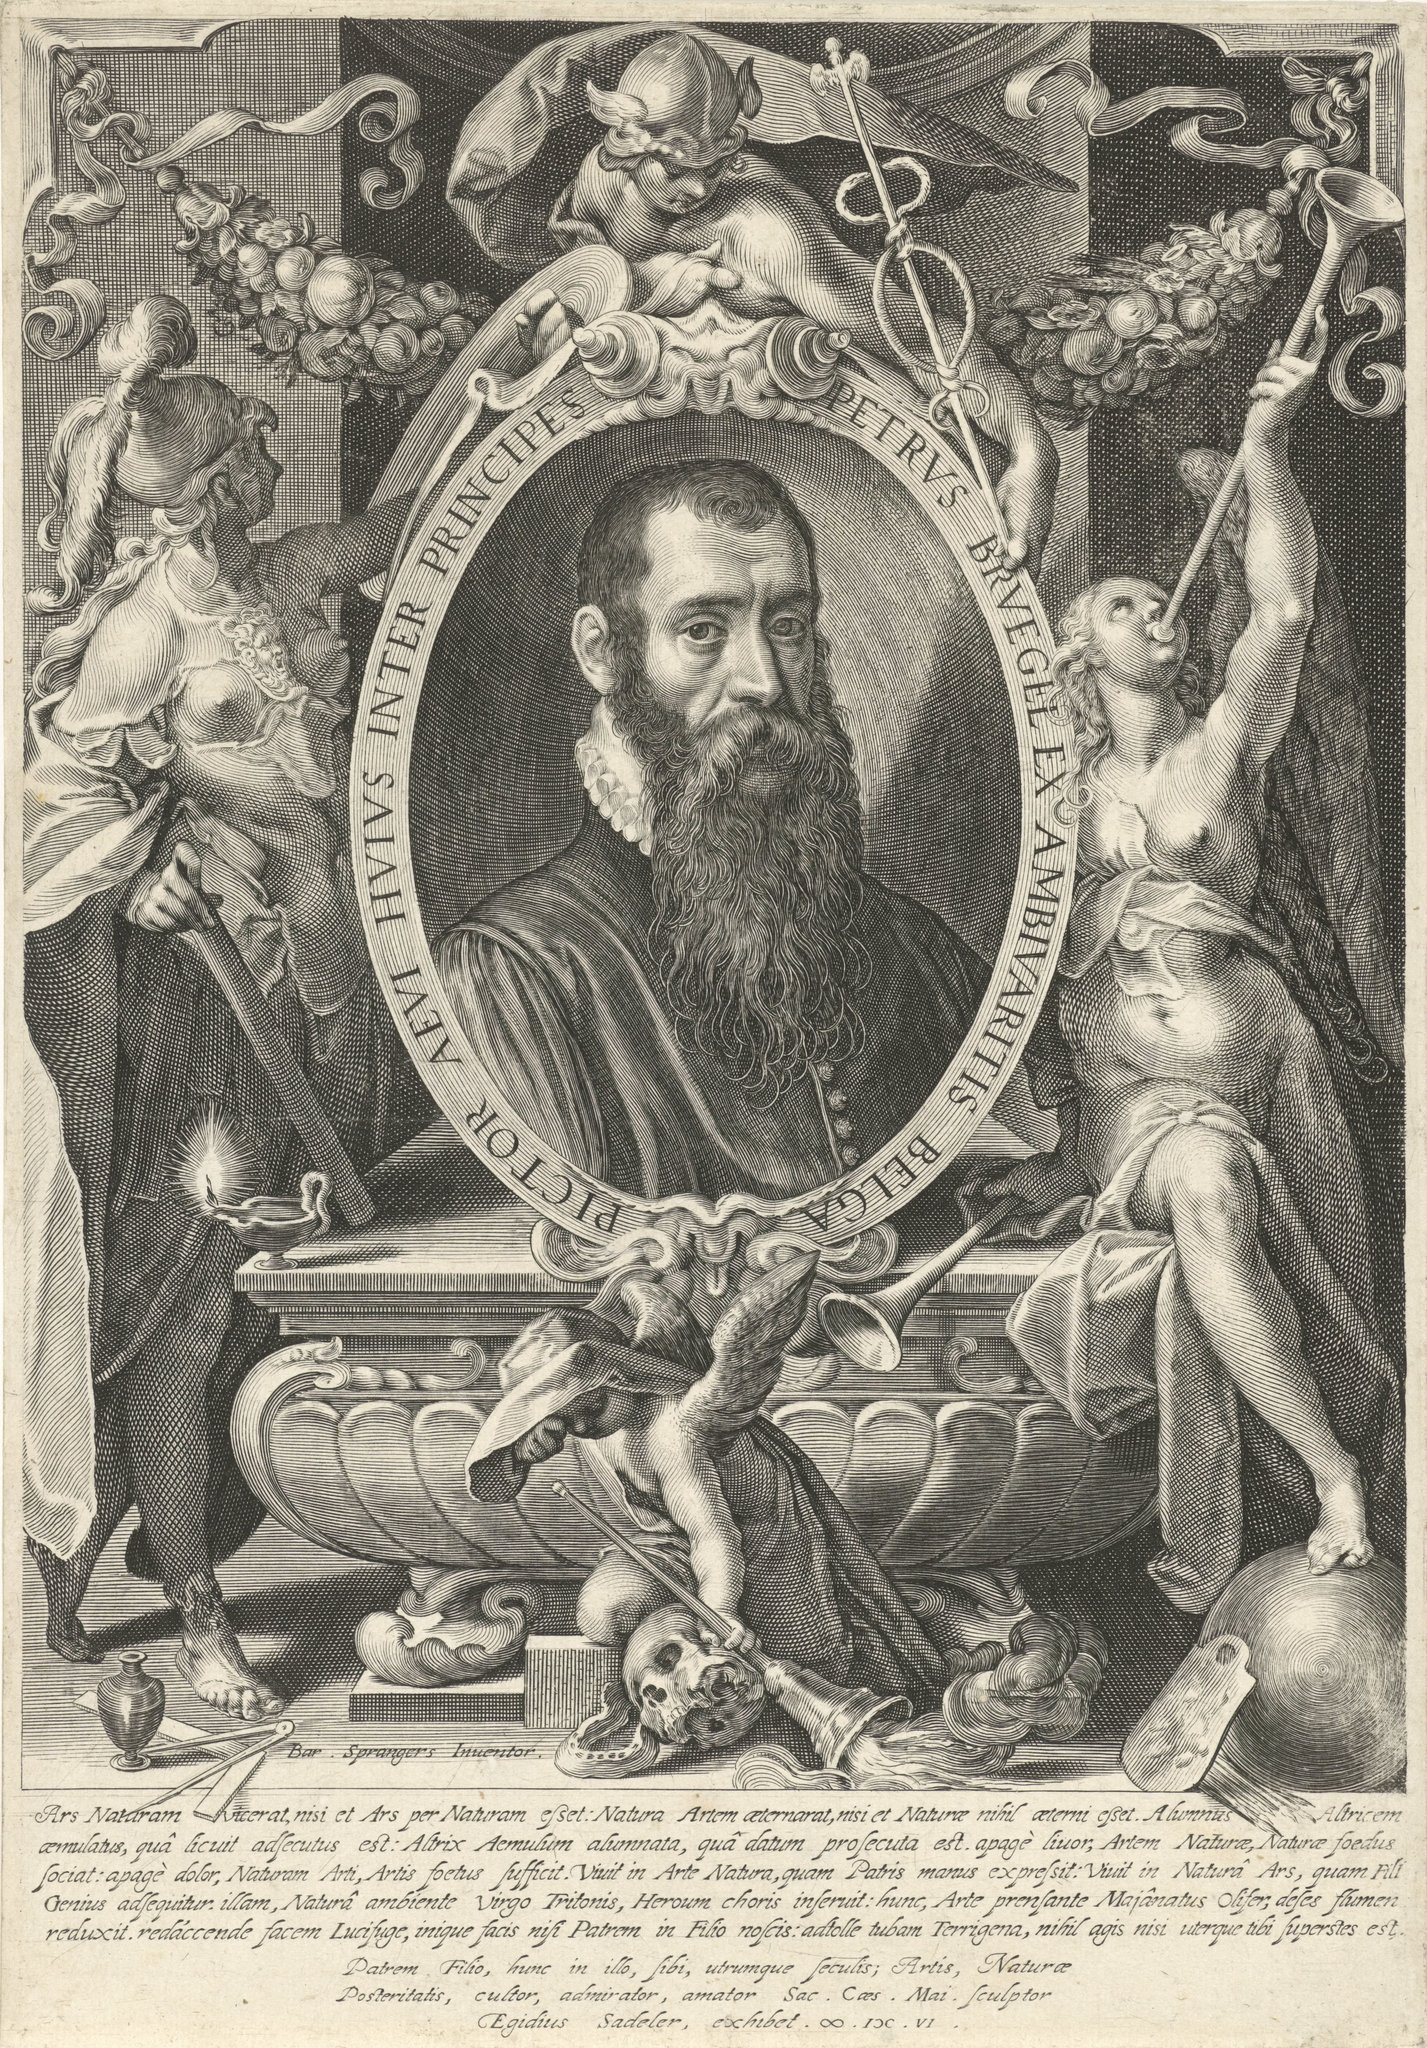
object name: print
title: Portret van Pieter Brueghel de jonge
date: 1606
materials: paper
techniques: engraving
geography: prague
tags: brussels, antwerp, draughtsman, pieter brueghel (ii), minerva as patroness, grave, tomb, portrait, self-portrait of painter, tools, implements of painter, fame; 'fama', 'fama buona', 'fama chiara' (ripa), specific aspects, allegorical aspects of mercury; mercury as patron, cupids: 'amores', 'amoretti', 'putti'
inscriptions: collector's mark: Lugt 240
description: Pieter Brueghel de Jonge, schilder, zoon van Pieter Brueghel de Oude. Portret met lange baard in ovale lijst, rustend op een graftombe, omringd door Minerva, Fama en Mercurius. Onder het portret een putto met doek over zijn hoofd in gebogen houding, die een fakkel omgekeerd houdt bij een doodshoofd. Aan de voeten van Fama liggen de attributen van de schilderkunst (palet) en penselen). Bij Minerva passer en winkelhaak. De prent heeft een Latijns onderschrift.